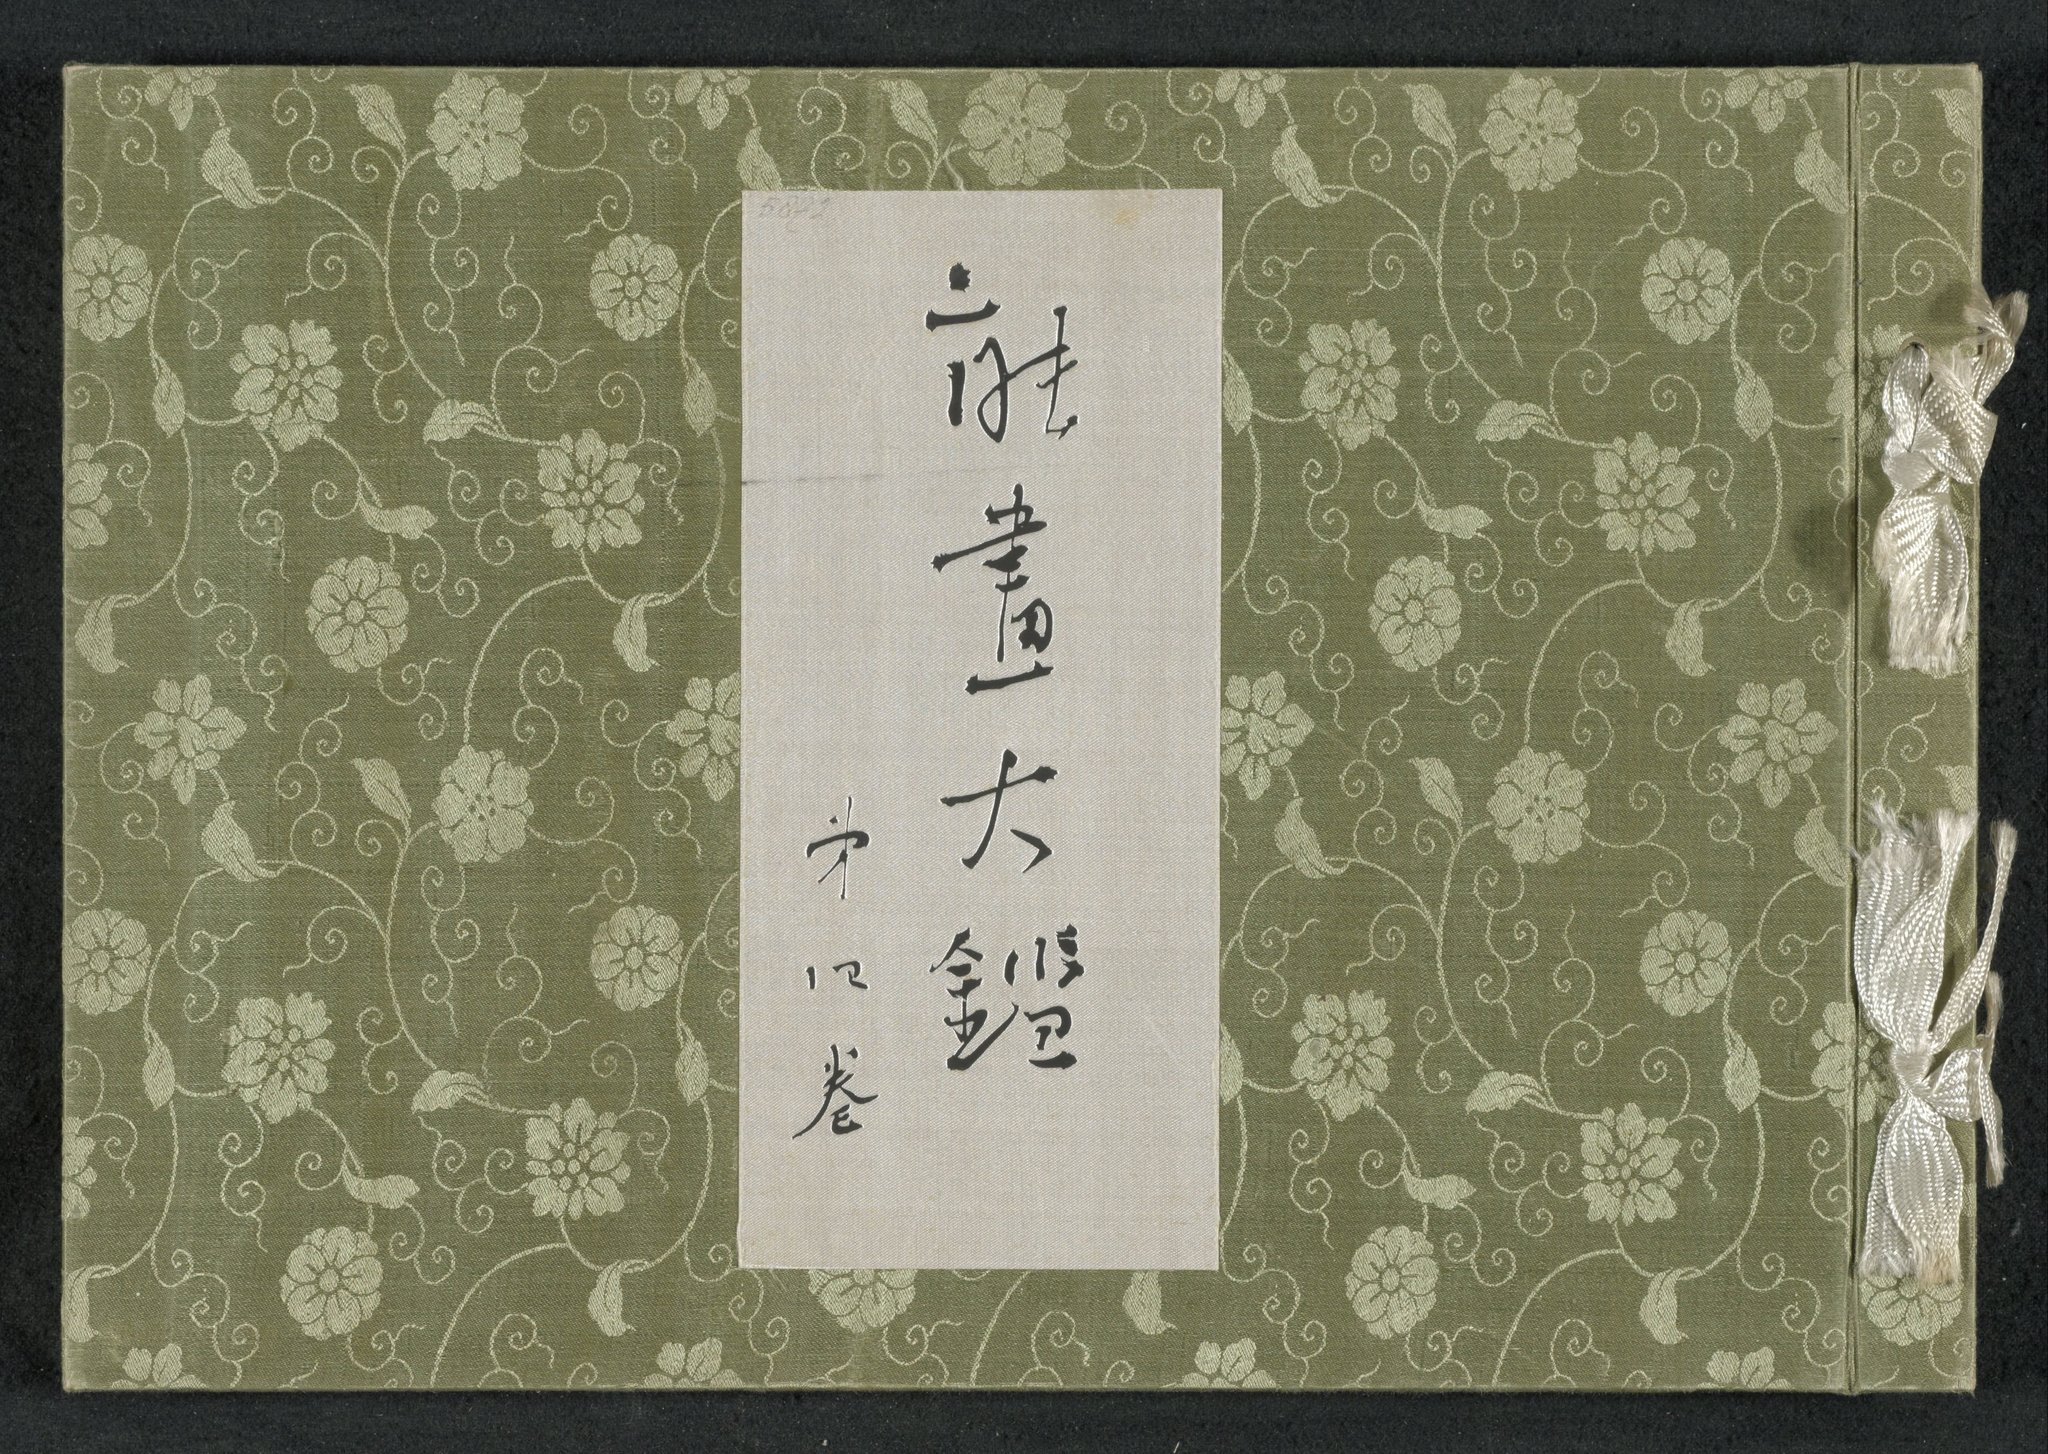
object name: picture book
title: Nôga taikan dai ichi maki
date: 1925-1926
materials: cardboard, paper, ribbon, silk, textile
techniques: woodcut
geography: japan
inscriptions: collector's mark: ‘Rijks-Ethnographisch Museum’